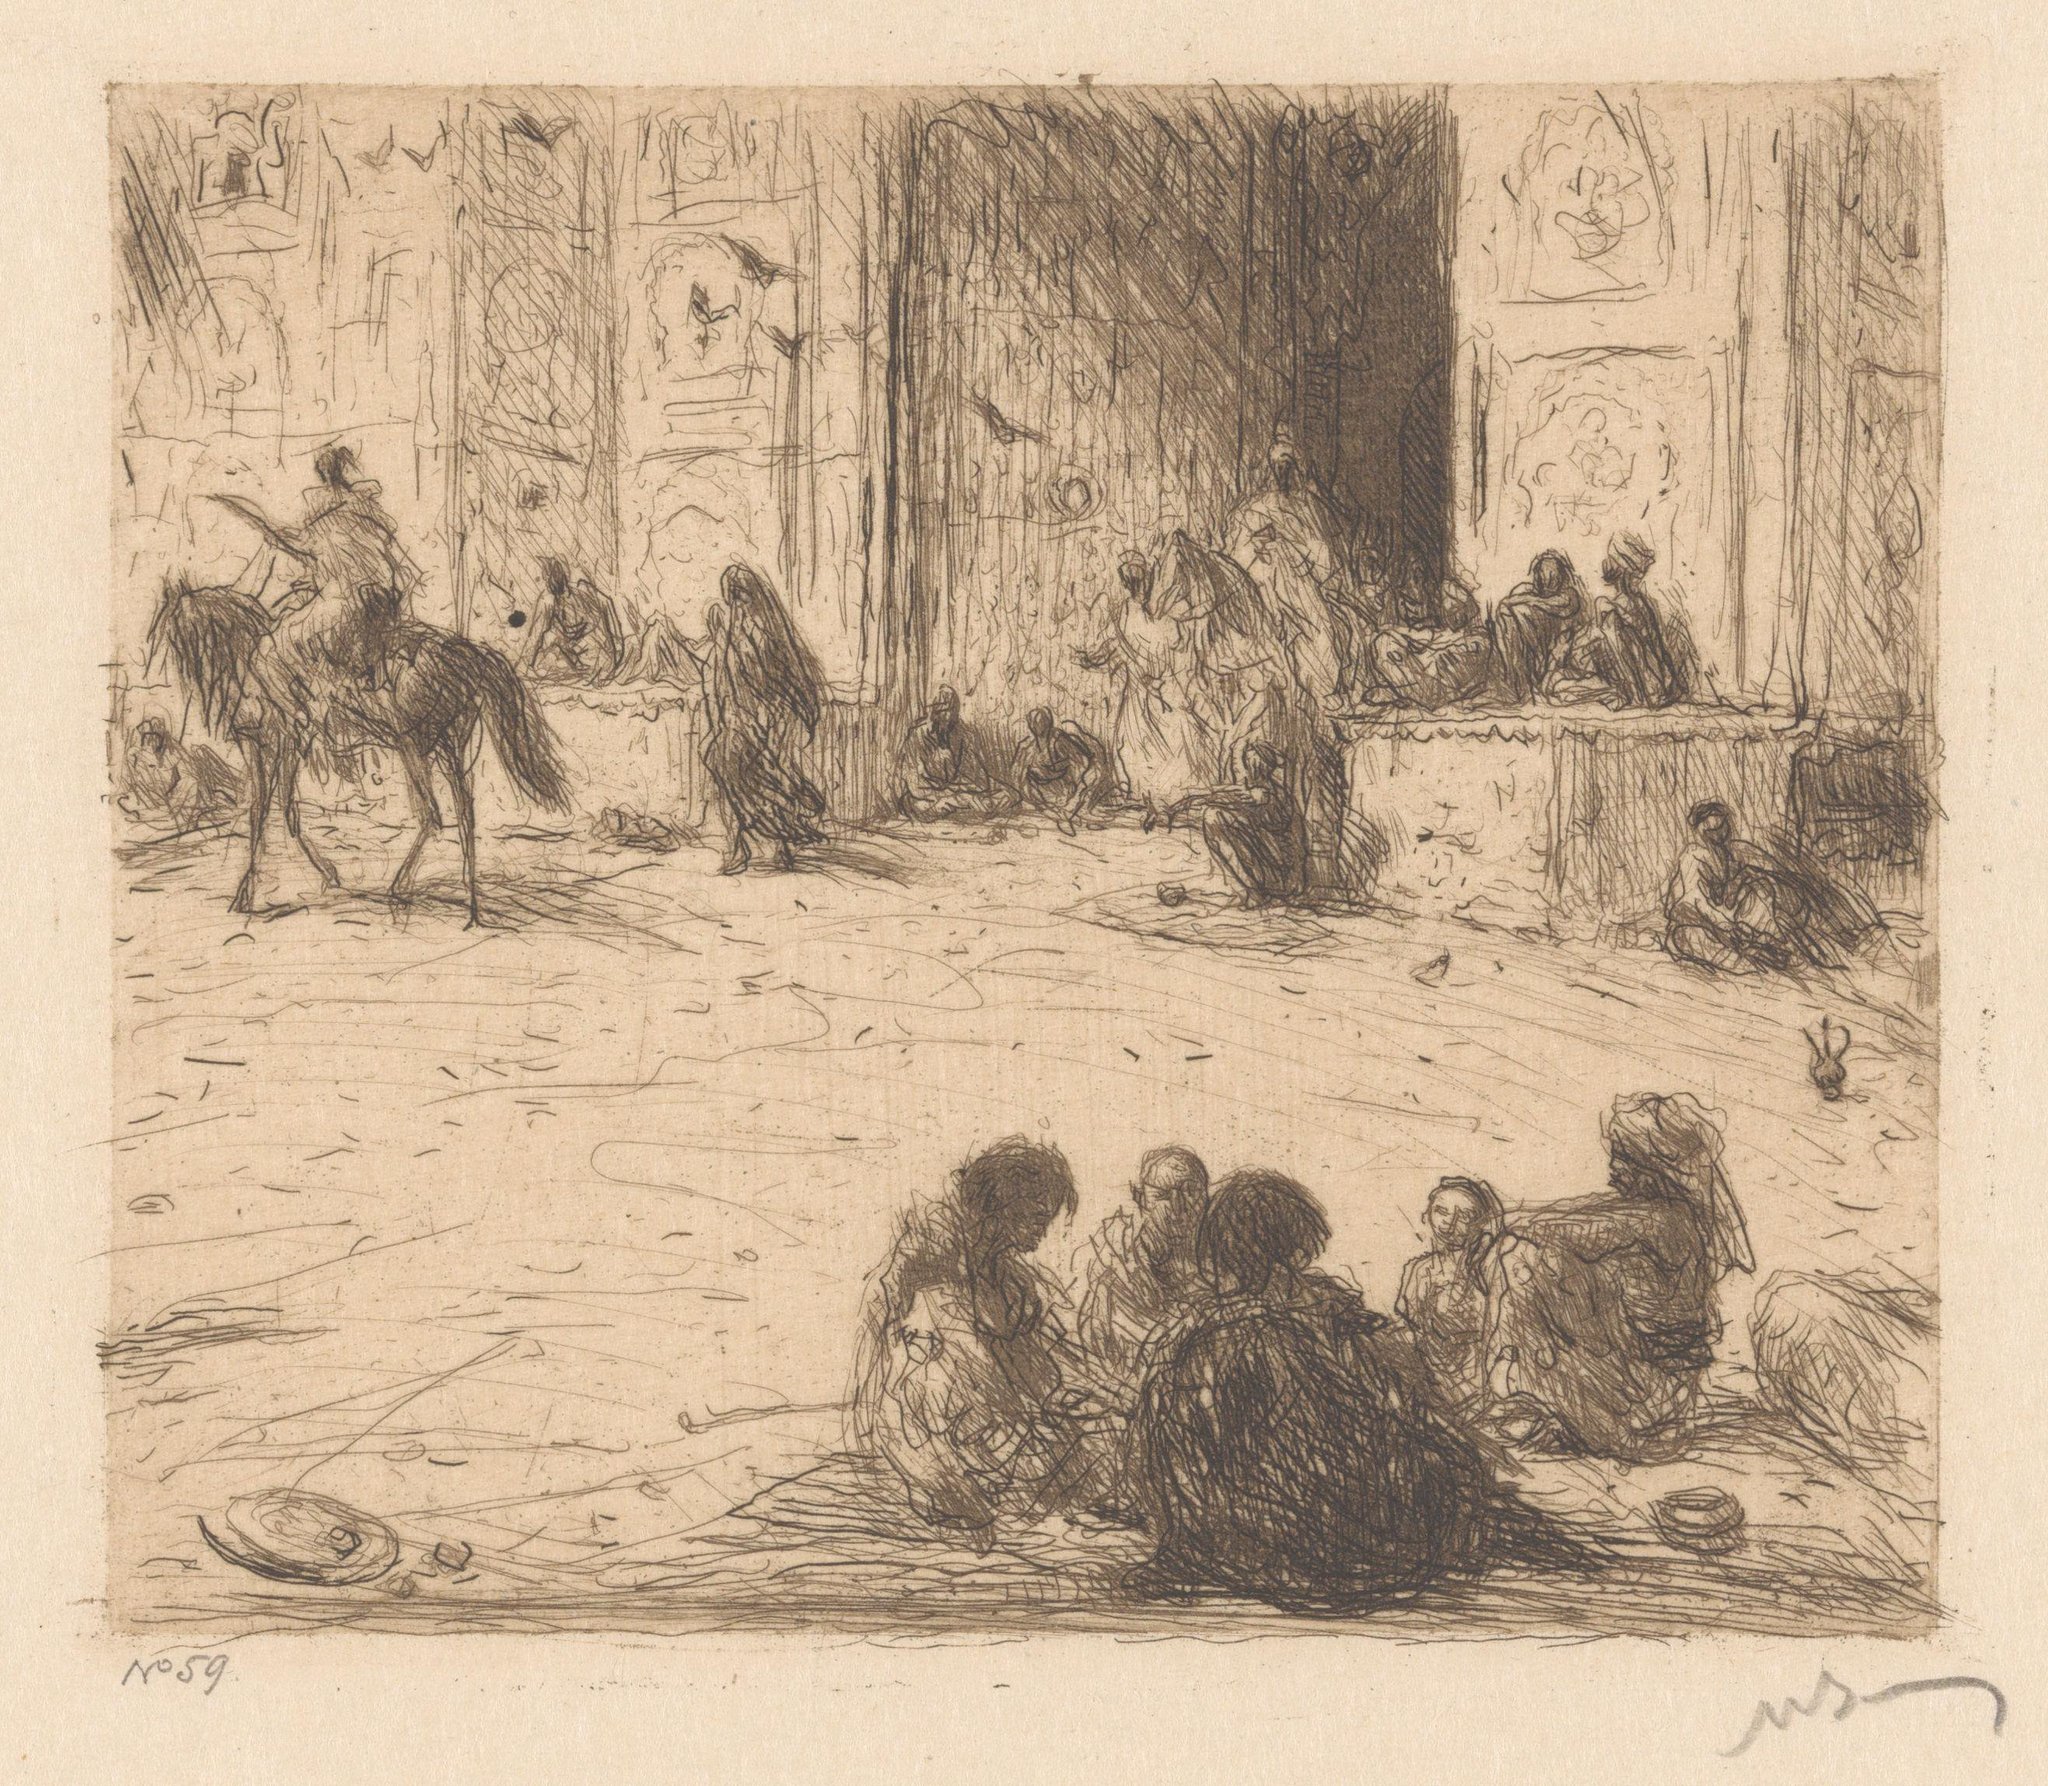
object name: print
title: Stadspoort in Jeypore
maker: marius bauer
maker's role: draughtsman, print maker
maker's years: 1867-1932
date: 1926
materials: paper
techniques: etching, intaglio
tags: riding a horse, ass, or mule; rider, horseman, city-gate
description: Een man op een paard rijdt door een stadspoort in Jeypore in Brits-Indië. Op straat nog een andere figuur te paard. Rechts op de voorgrond en aan weerszijden van de stadspoort zittende figuren.